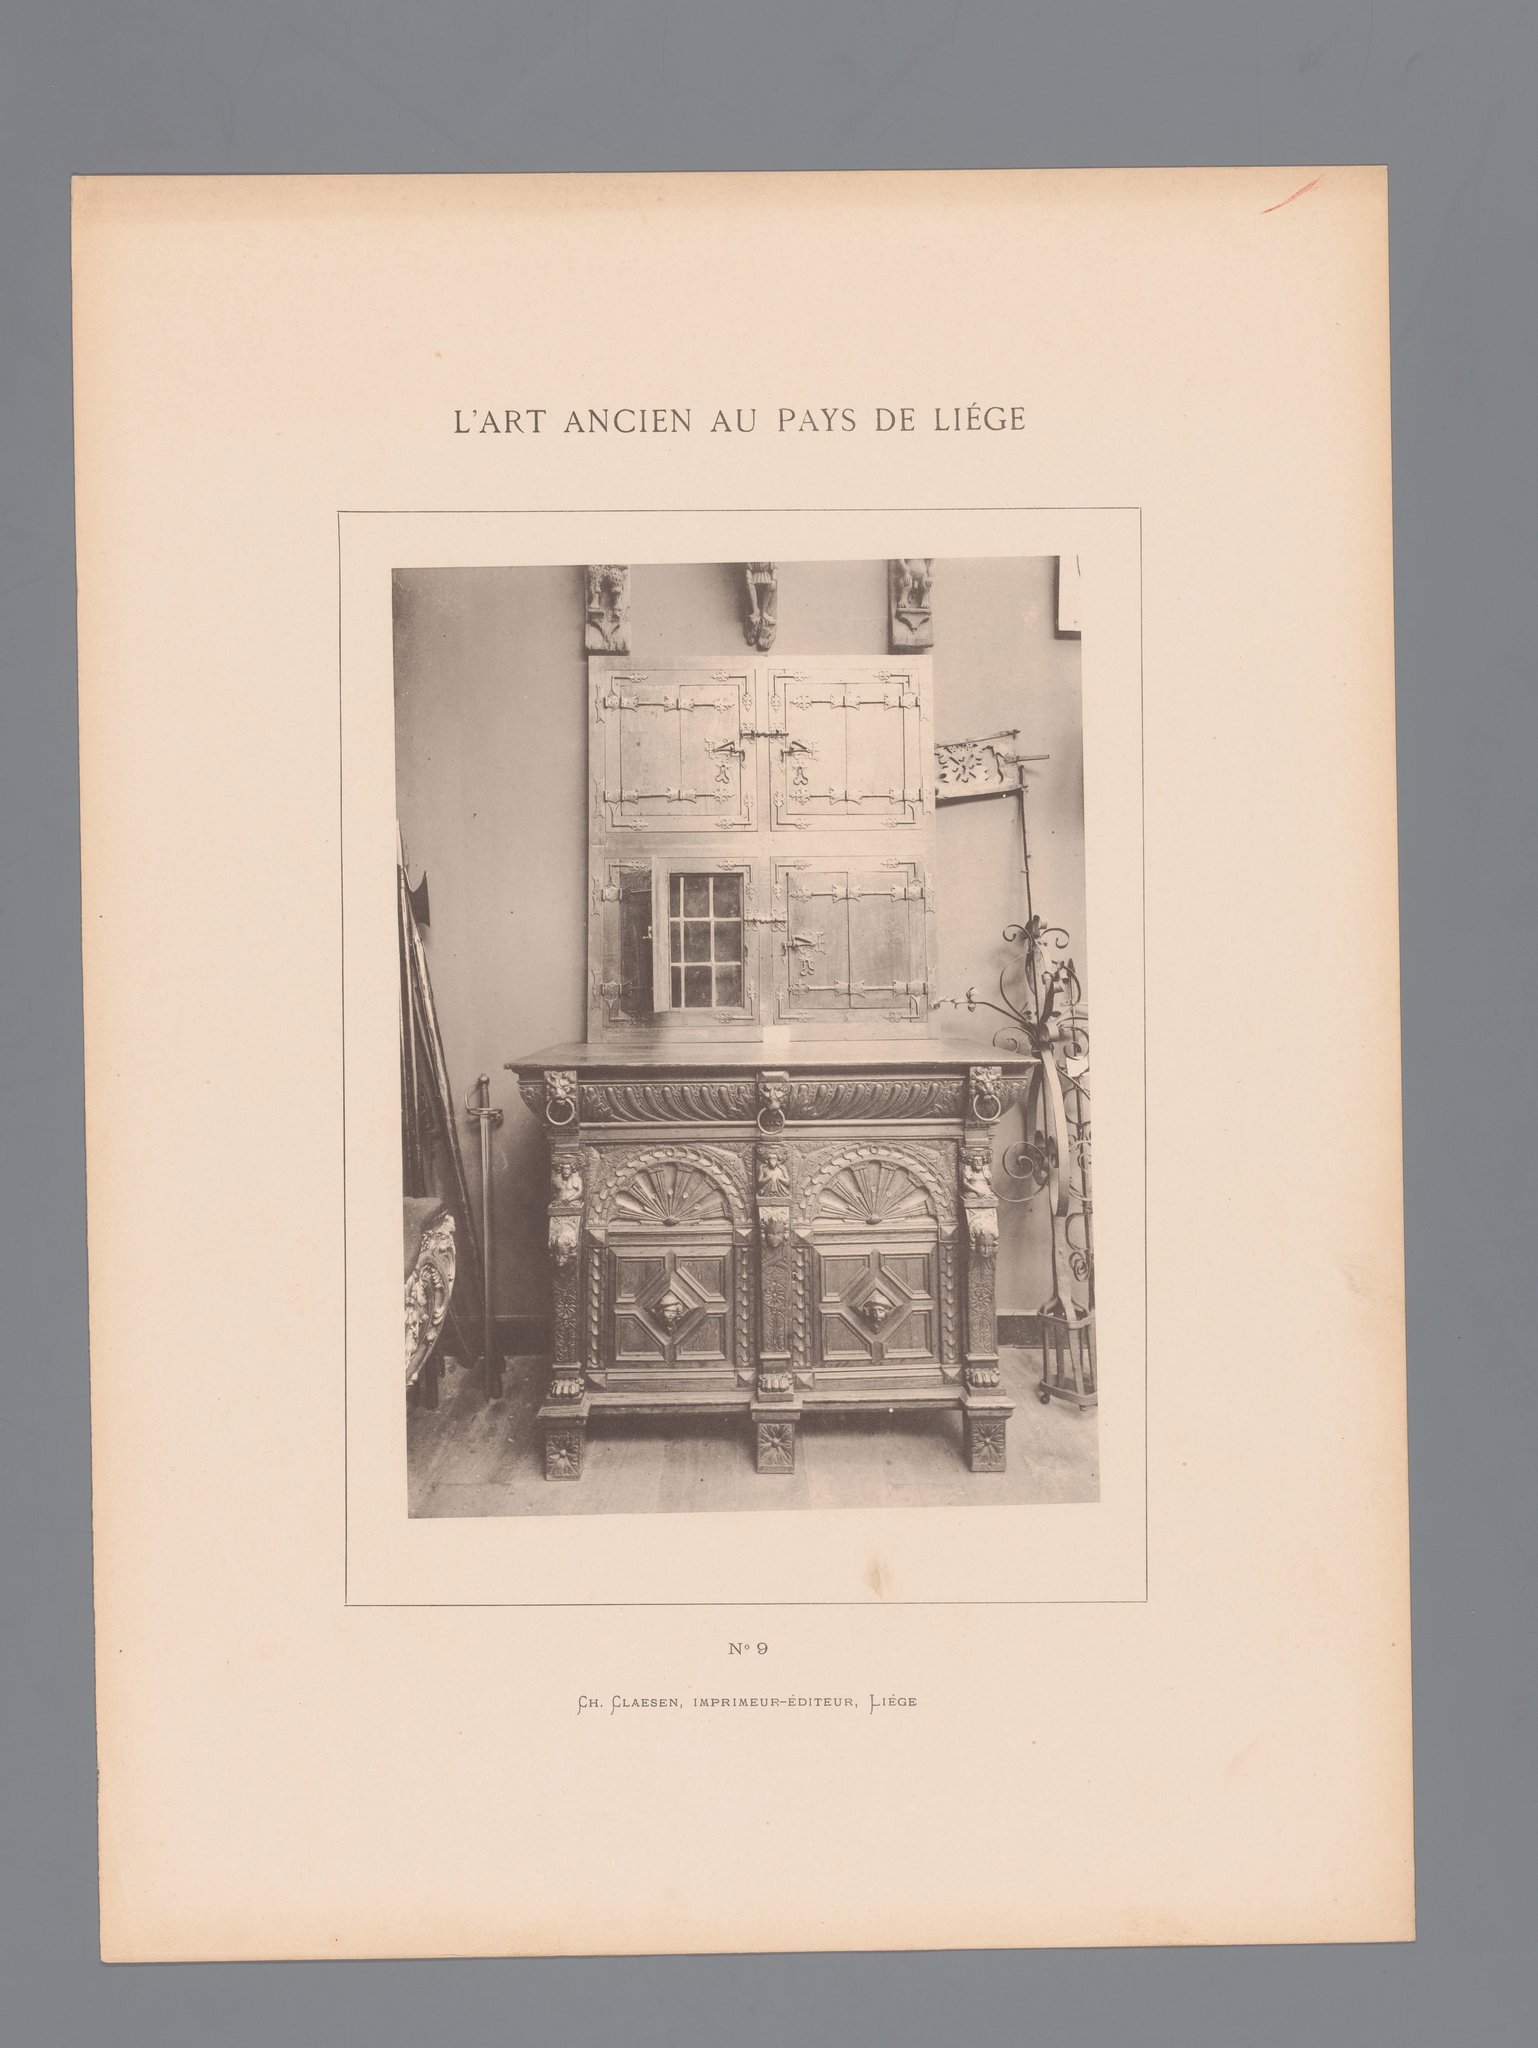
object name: photomechanical print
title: L'Art Ancien au Pays de Liége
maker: Anonymous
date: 1879-1884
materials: paper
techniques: photograph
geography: liège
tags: ornamental cupboard (+ wood and other phytogenic material), permanent exhibition, museum, liège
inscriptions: number: ‘No 9’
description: Deze prent maakt deel uit van een omslag met twintig prenten, een titelblad en een lijst van afbeeldingen.